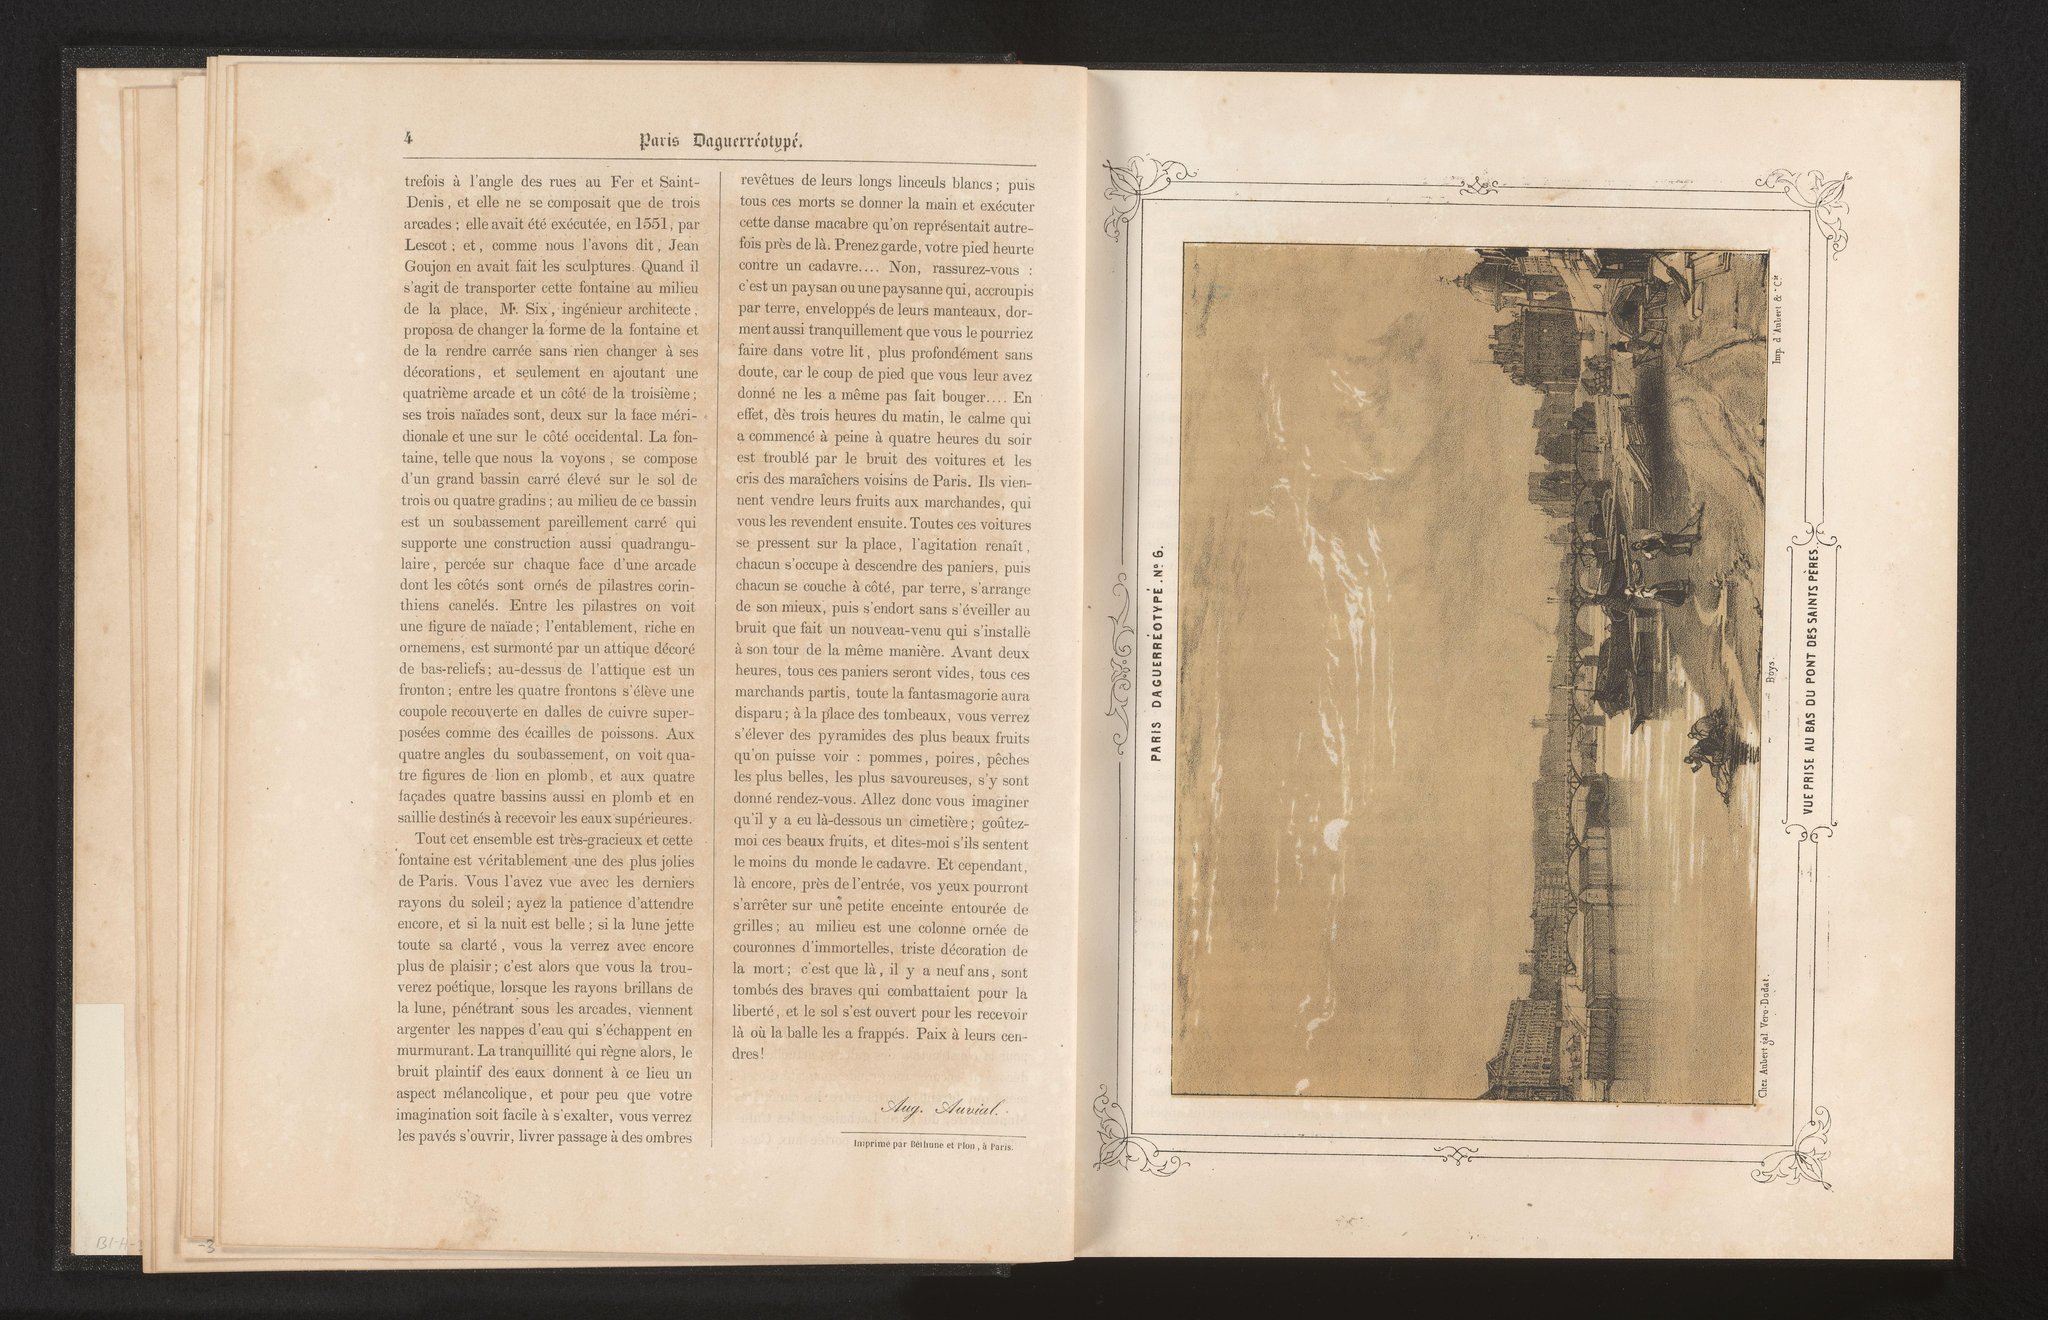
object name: page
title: Vue prise au bas du Pont des Saint-Pères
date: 1839-1840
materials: paper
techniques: tone lithography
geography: paris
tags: bridge in city across river, canal, etc.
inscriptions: inscription: ‘PARIS DAGUERRÉOTYPÉ No. 6.’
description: Prent op eenentwintigste ongenummerde pagina.